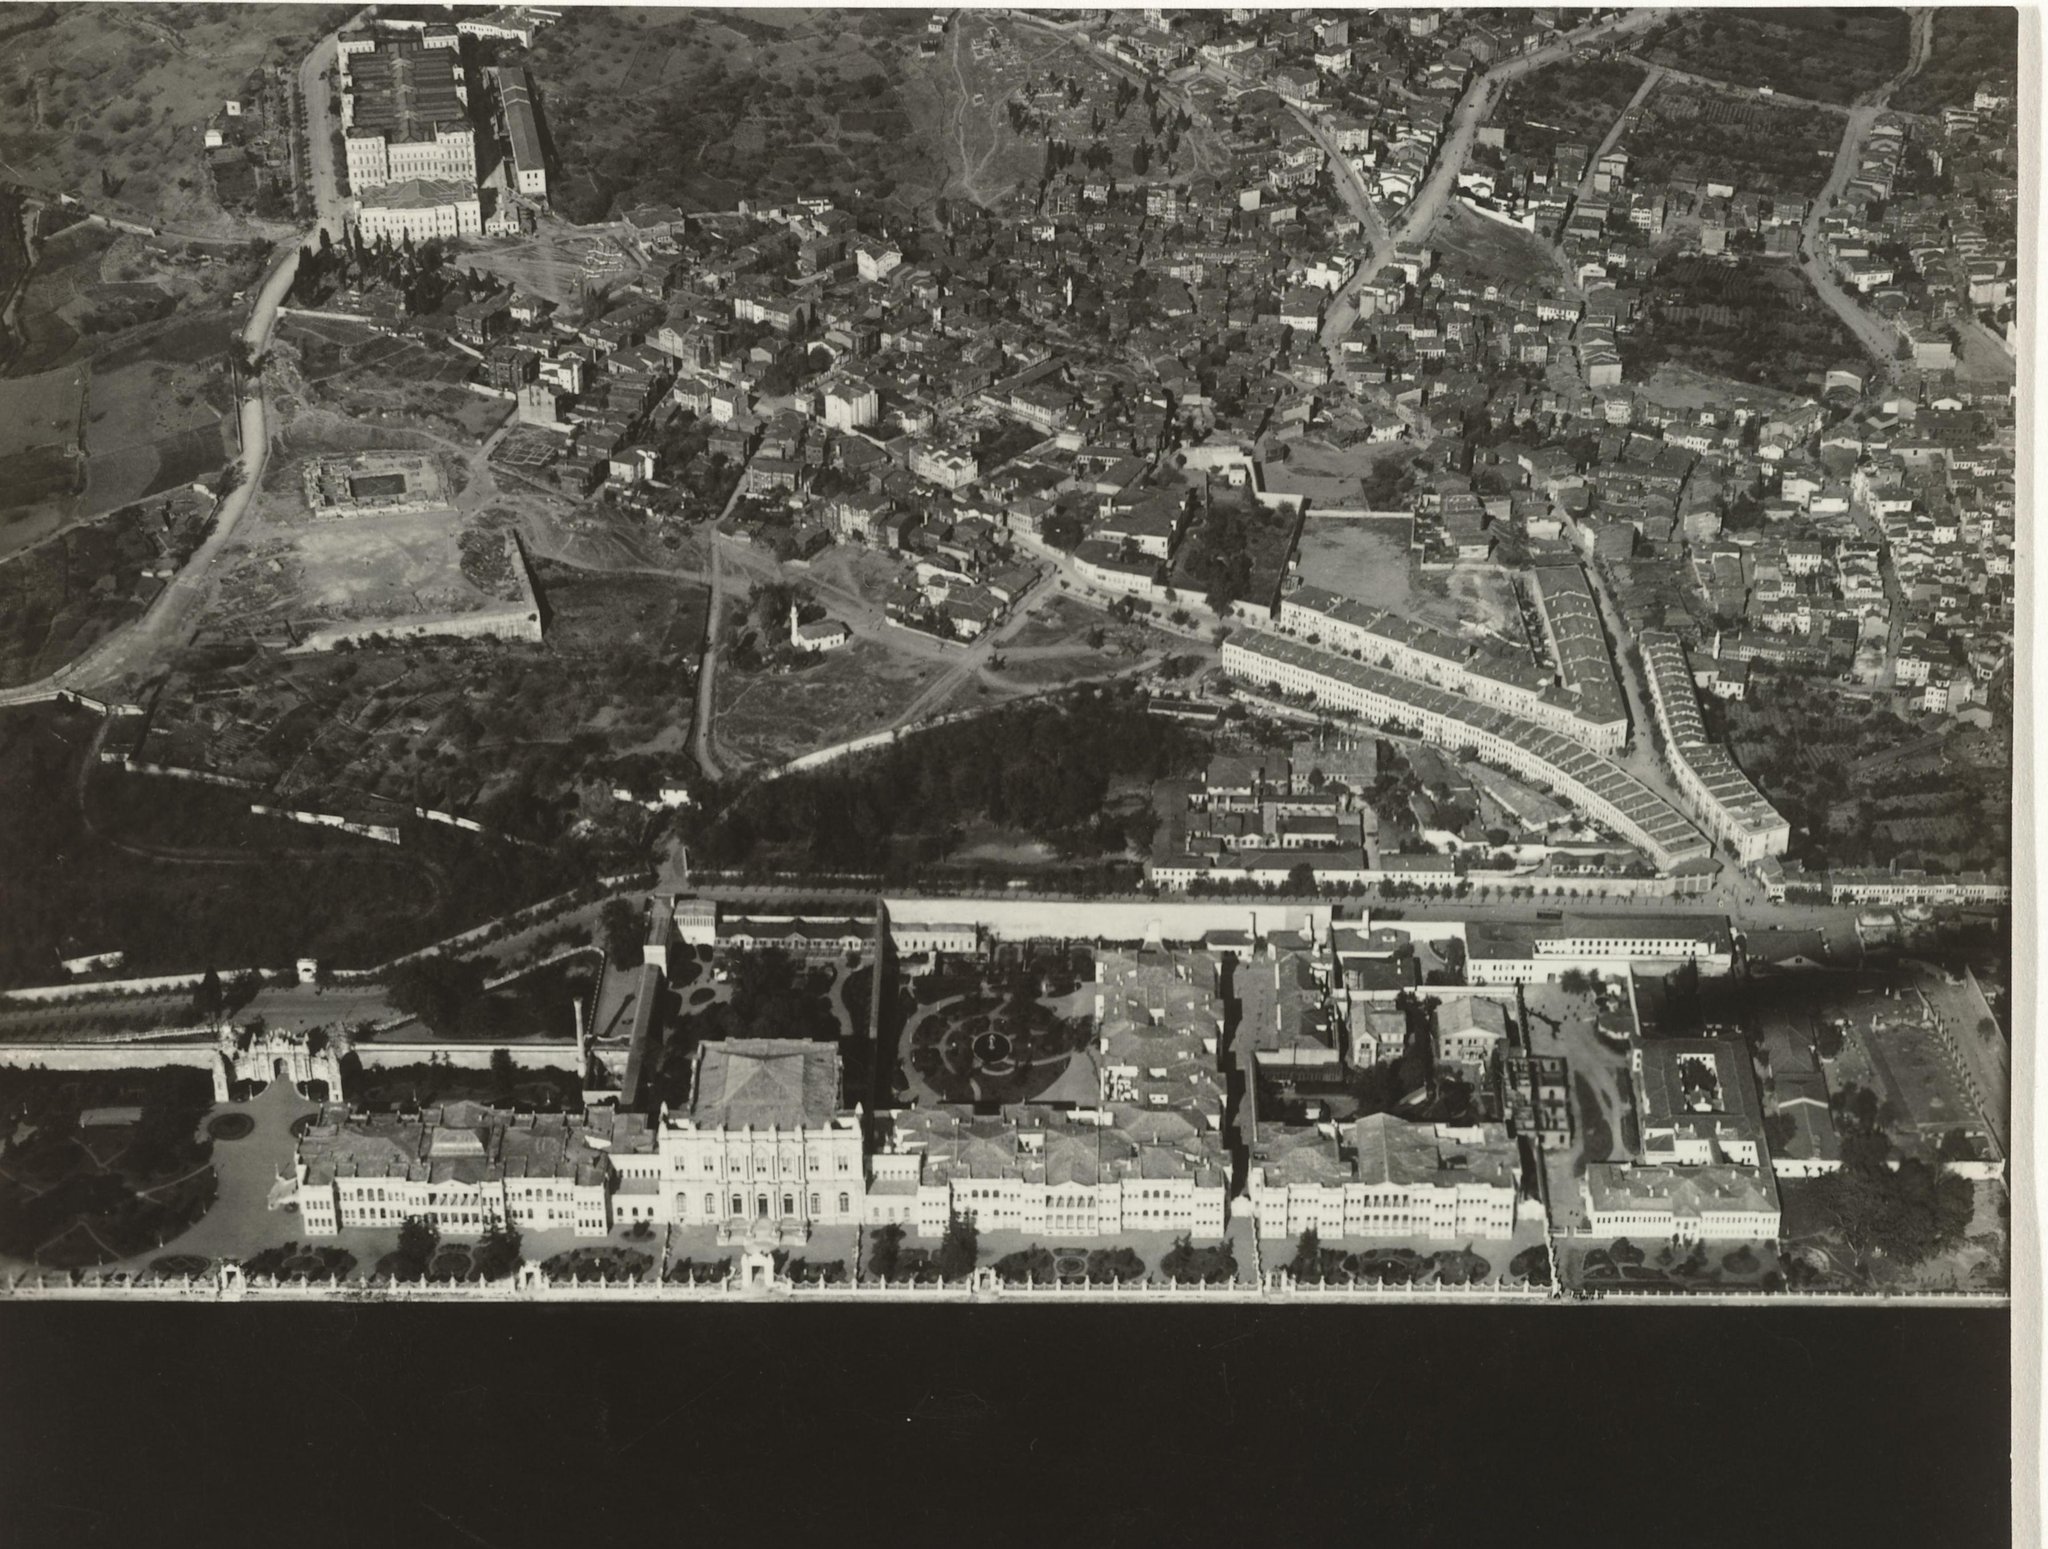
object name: photograph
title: Luchtfoto in zwart-wit van een stad of dorp gelegen aan het water, met een lange U-vormige rij gebouwen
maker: Anonymous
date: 1930-1975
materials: photographic support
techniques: gelatin silver print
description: Luchtfoto in zwart-wit van een stad of dorp gelegen aan het water, met een lange U-vormige rij gebouwen (rechts, midden).